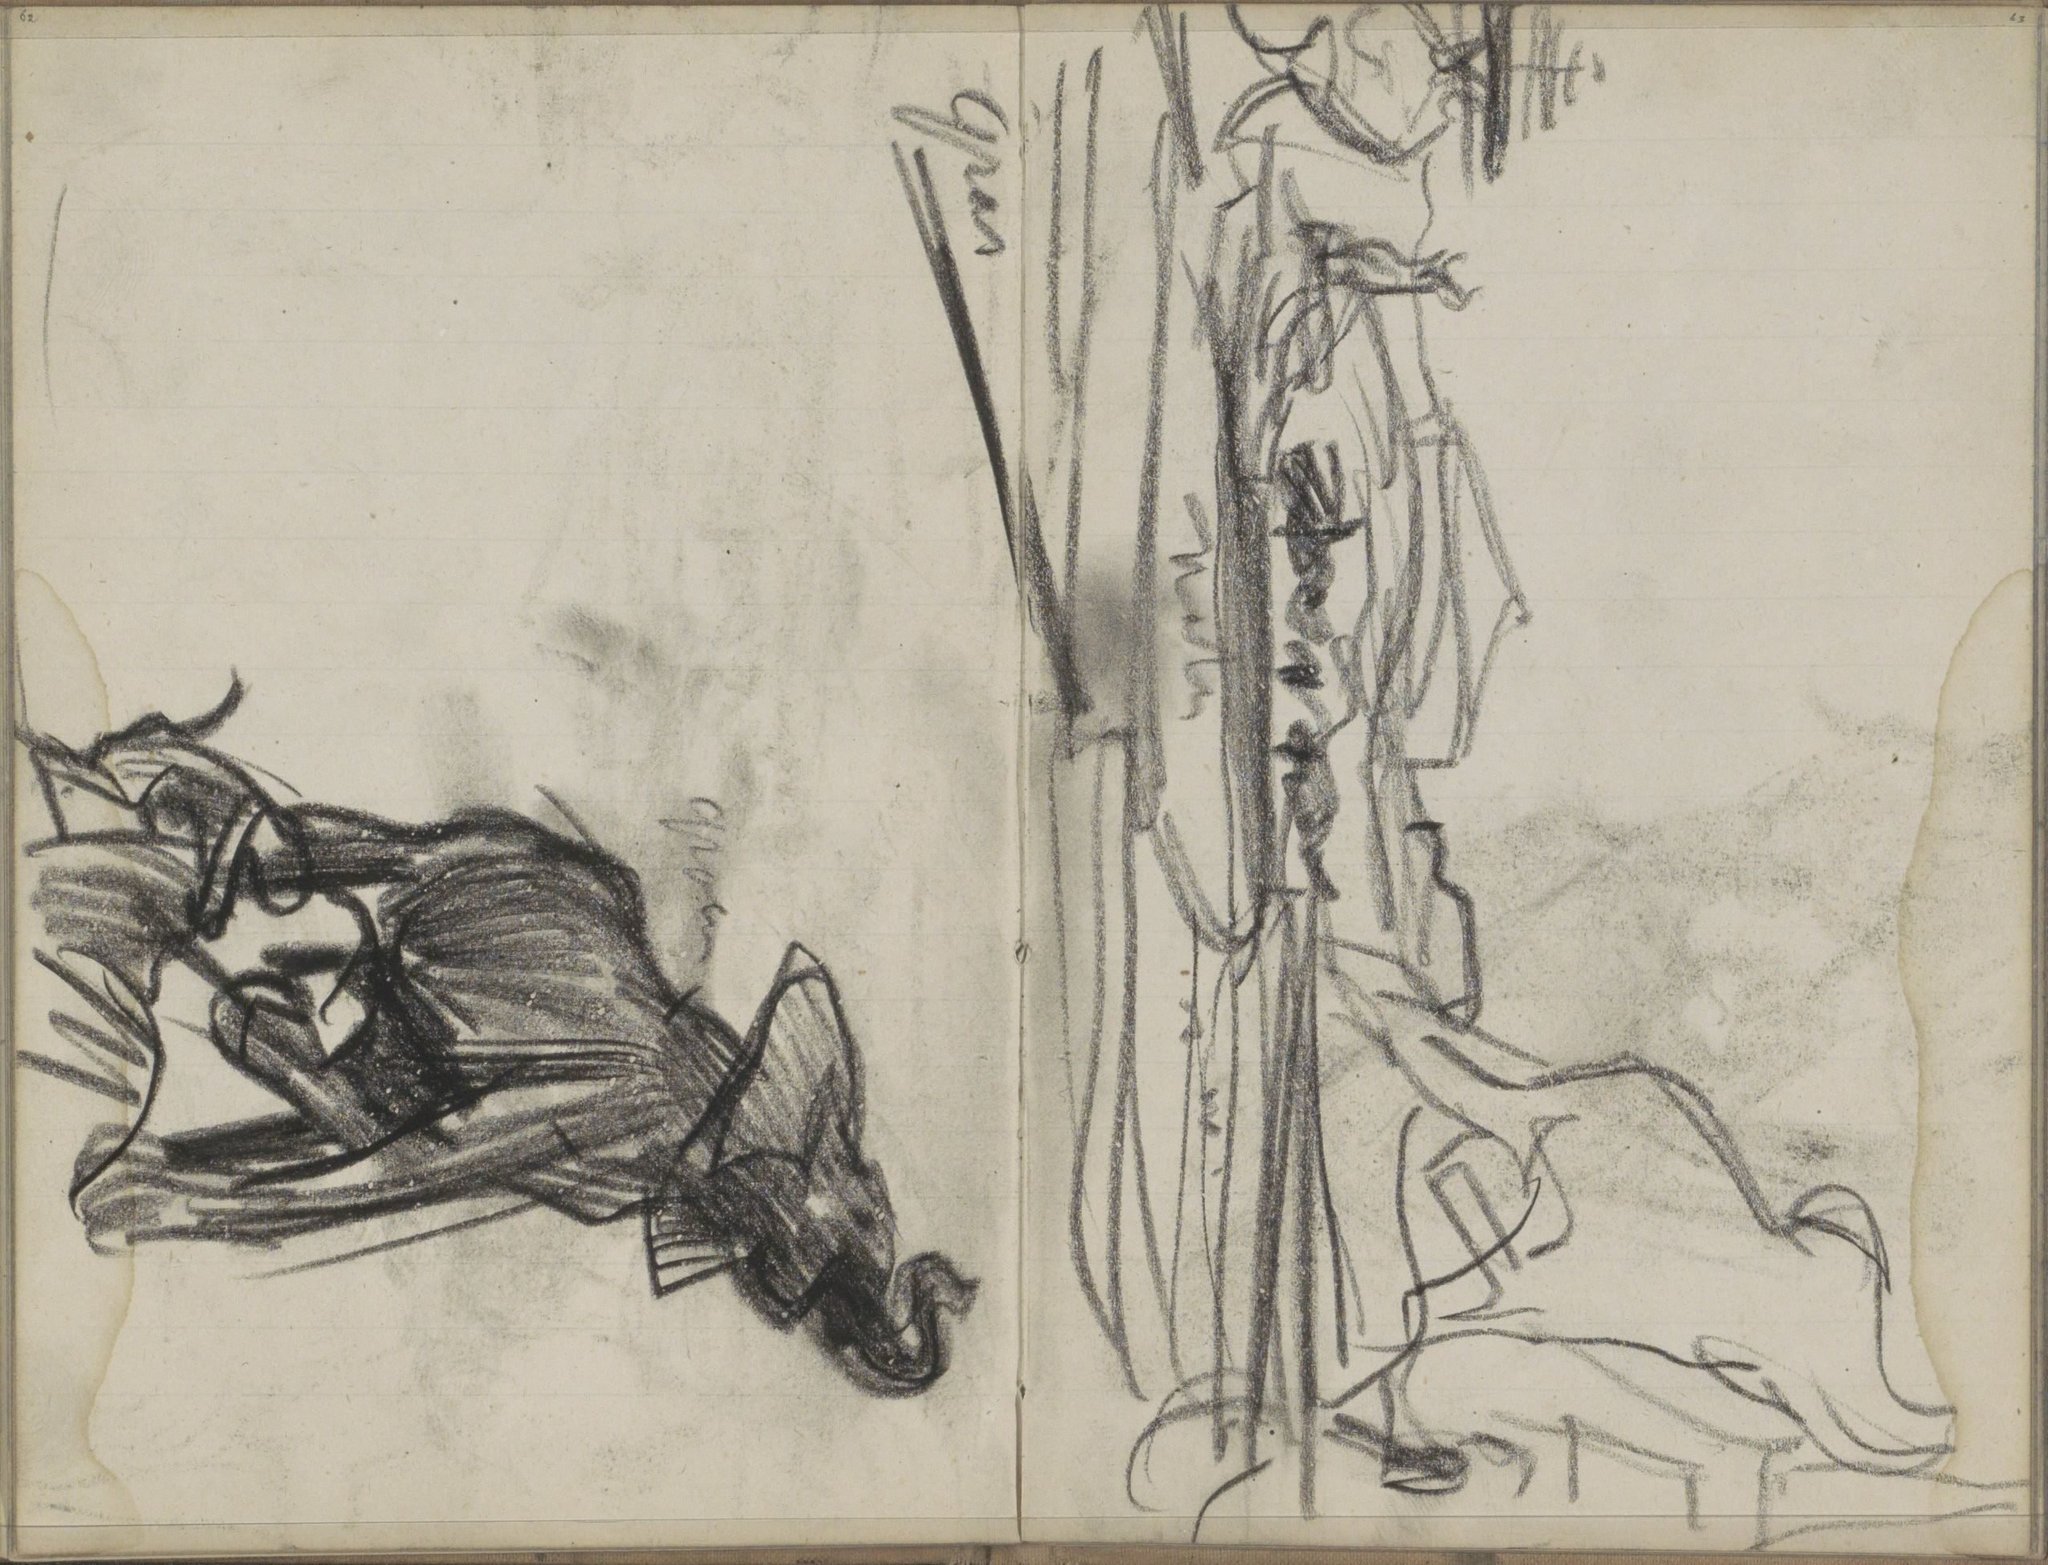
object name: sketchbook leaf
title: Landschap met water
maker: marius bauer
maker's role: draughtsman, print maker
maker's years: 1867-1932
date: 1888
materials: chalk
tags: landscapes with waters, waterscapes, seascapes (in the temperate zone)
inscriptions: annotation: ‘water’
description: Pagina 63 uit een schetsboek met 49 bladen.